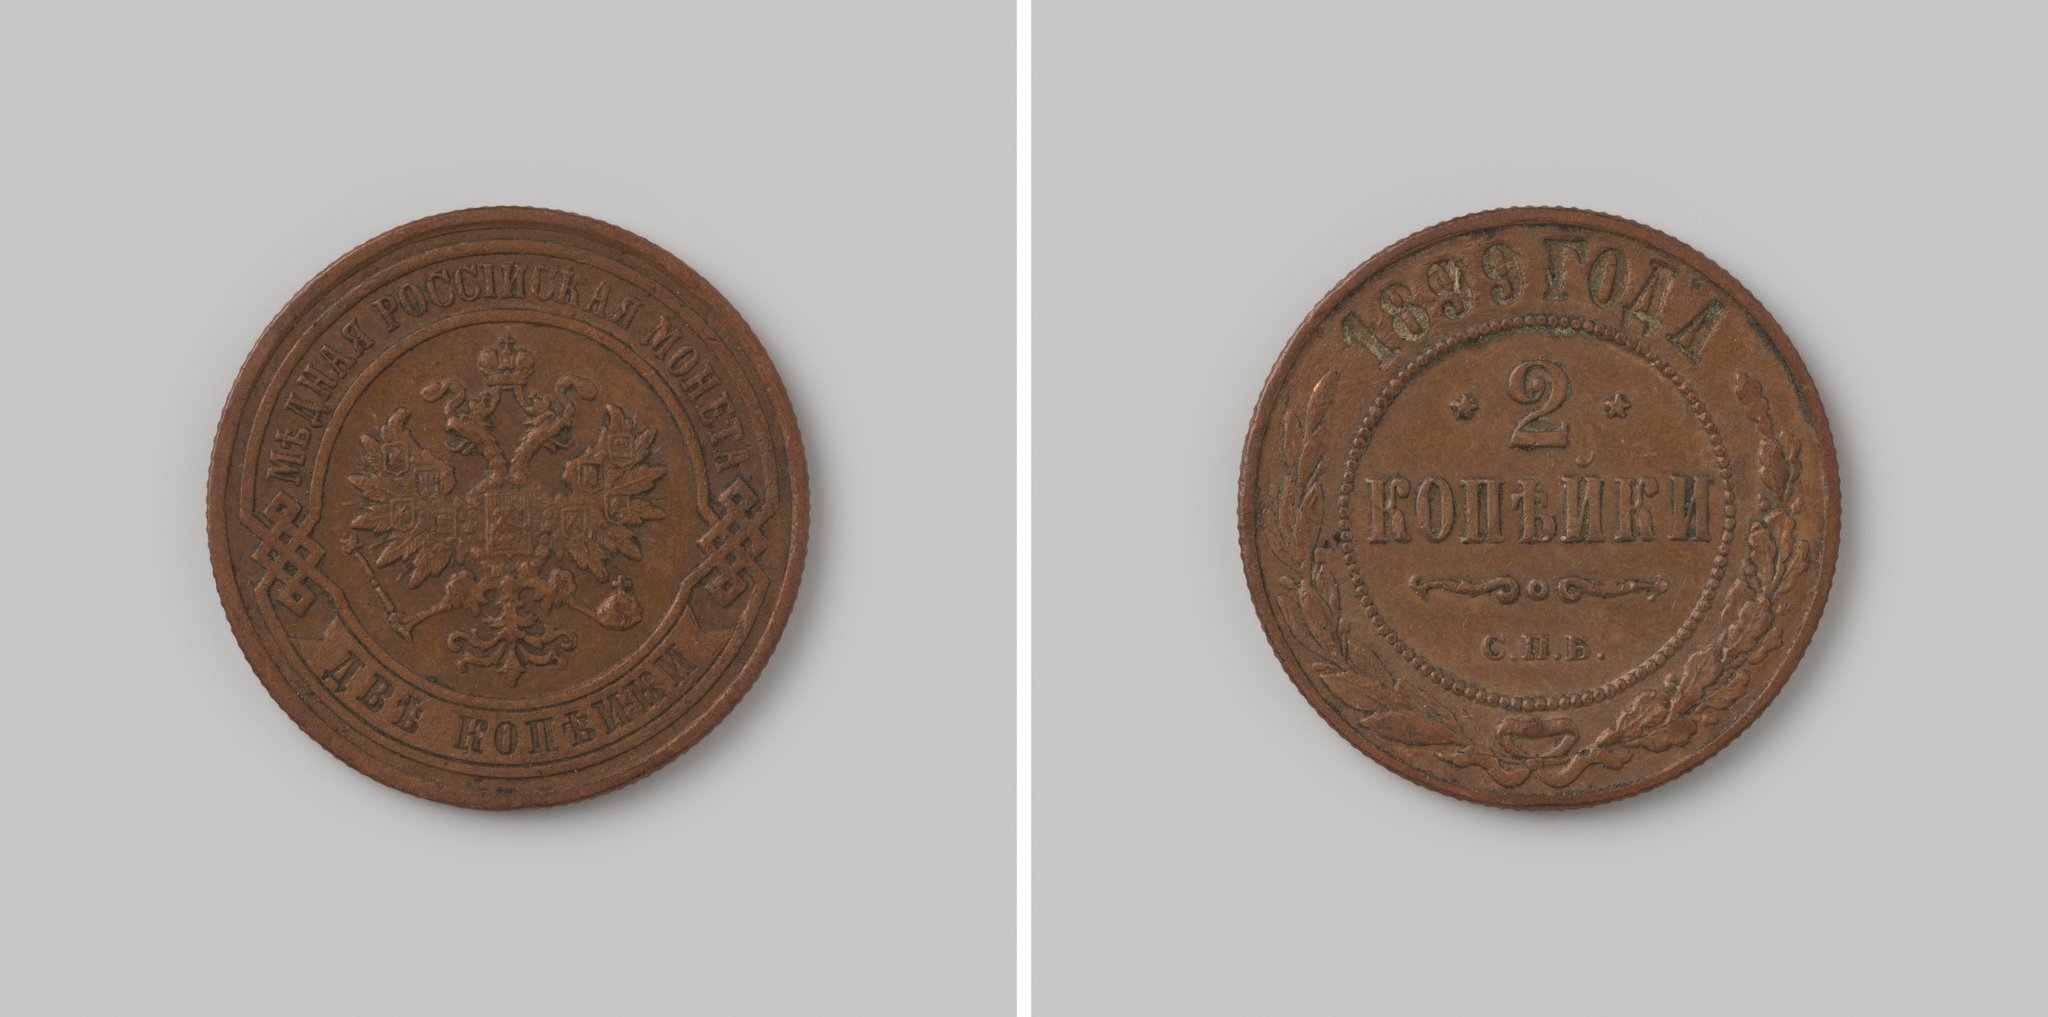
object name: coin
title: Rusland, tsaar Nicholai II, 2 kopeken,1899 SPB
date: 1899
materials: copper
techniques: striking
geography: sint-petersburg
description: Zilveren munt. Voorzijde: dubbelkoppige gekroonde adelaar met gespreide vleugels en met op zijn vleugels kleine wapenschilden en op zijn borst een groot, met een ridderorde omhangen wapenschild en in zijn poten een scepter en een gekroonde bol. Boven de adelaar een kroon met lint. Waarde-aanduiding in omschrift onderaan. Keerzijde: tussen twee samengebonden takken in twee regels waarde-aanduiding. Daaronder in het Cyrillisch de letters S,P en B [=Sint Petersburg]. Jaartal bovenaan in omschrift. Kartelrand.